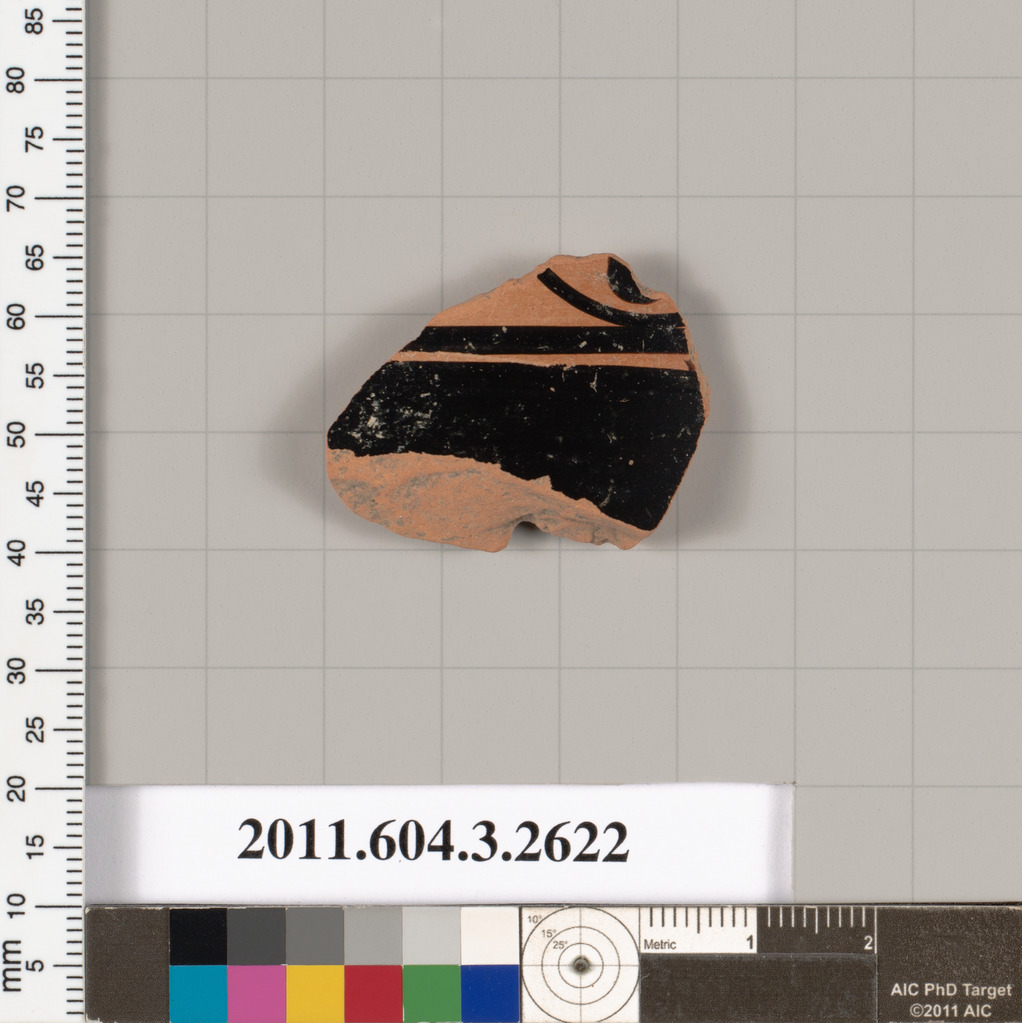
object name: kylix fragment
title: Terracotta fragment of a kylix (drinking cup)?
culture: greek, attic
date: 525-501 BCE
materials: terracotta